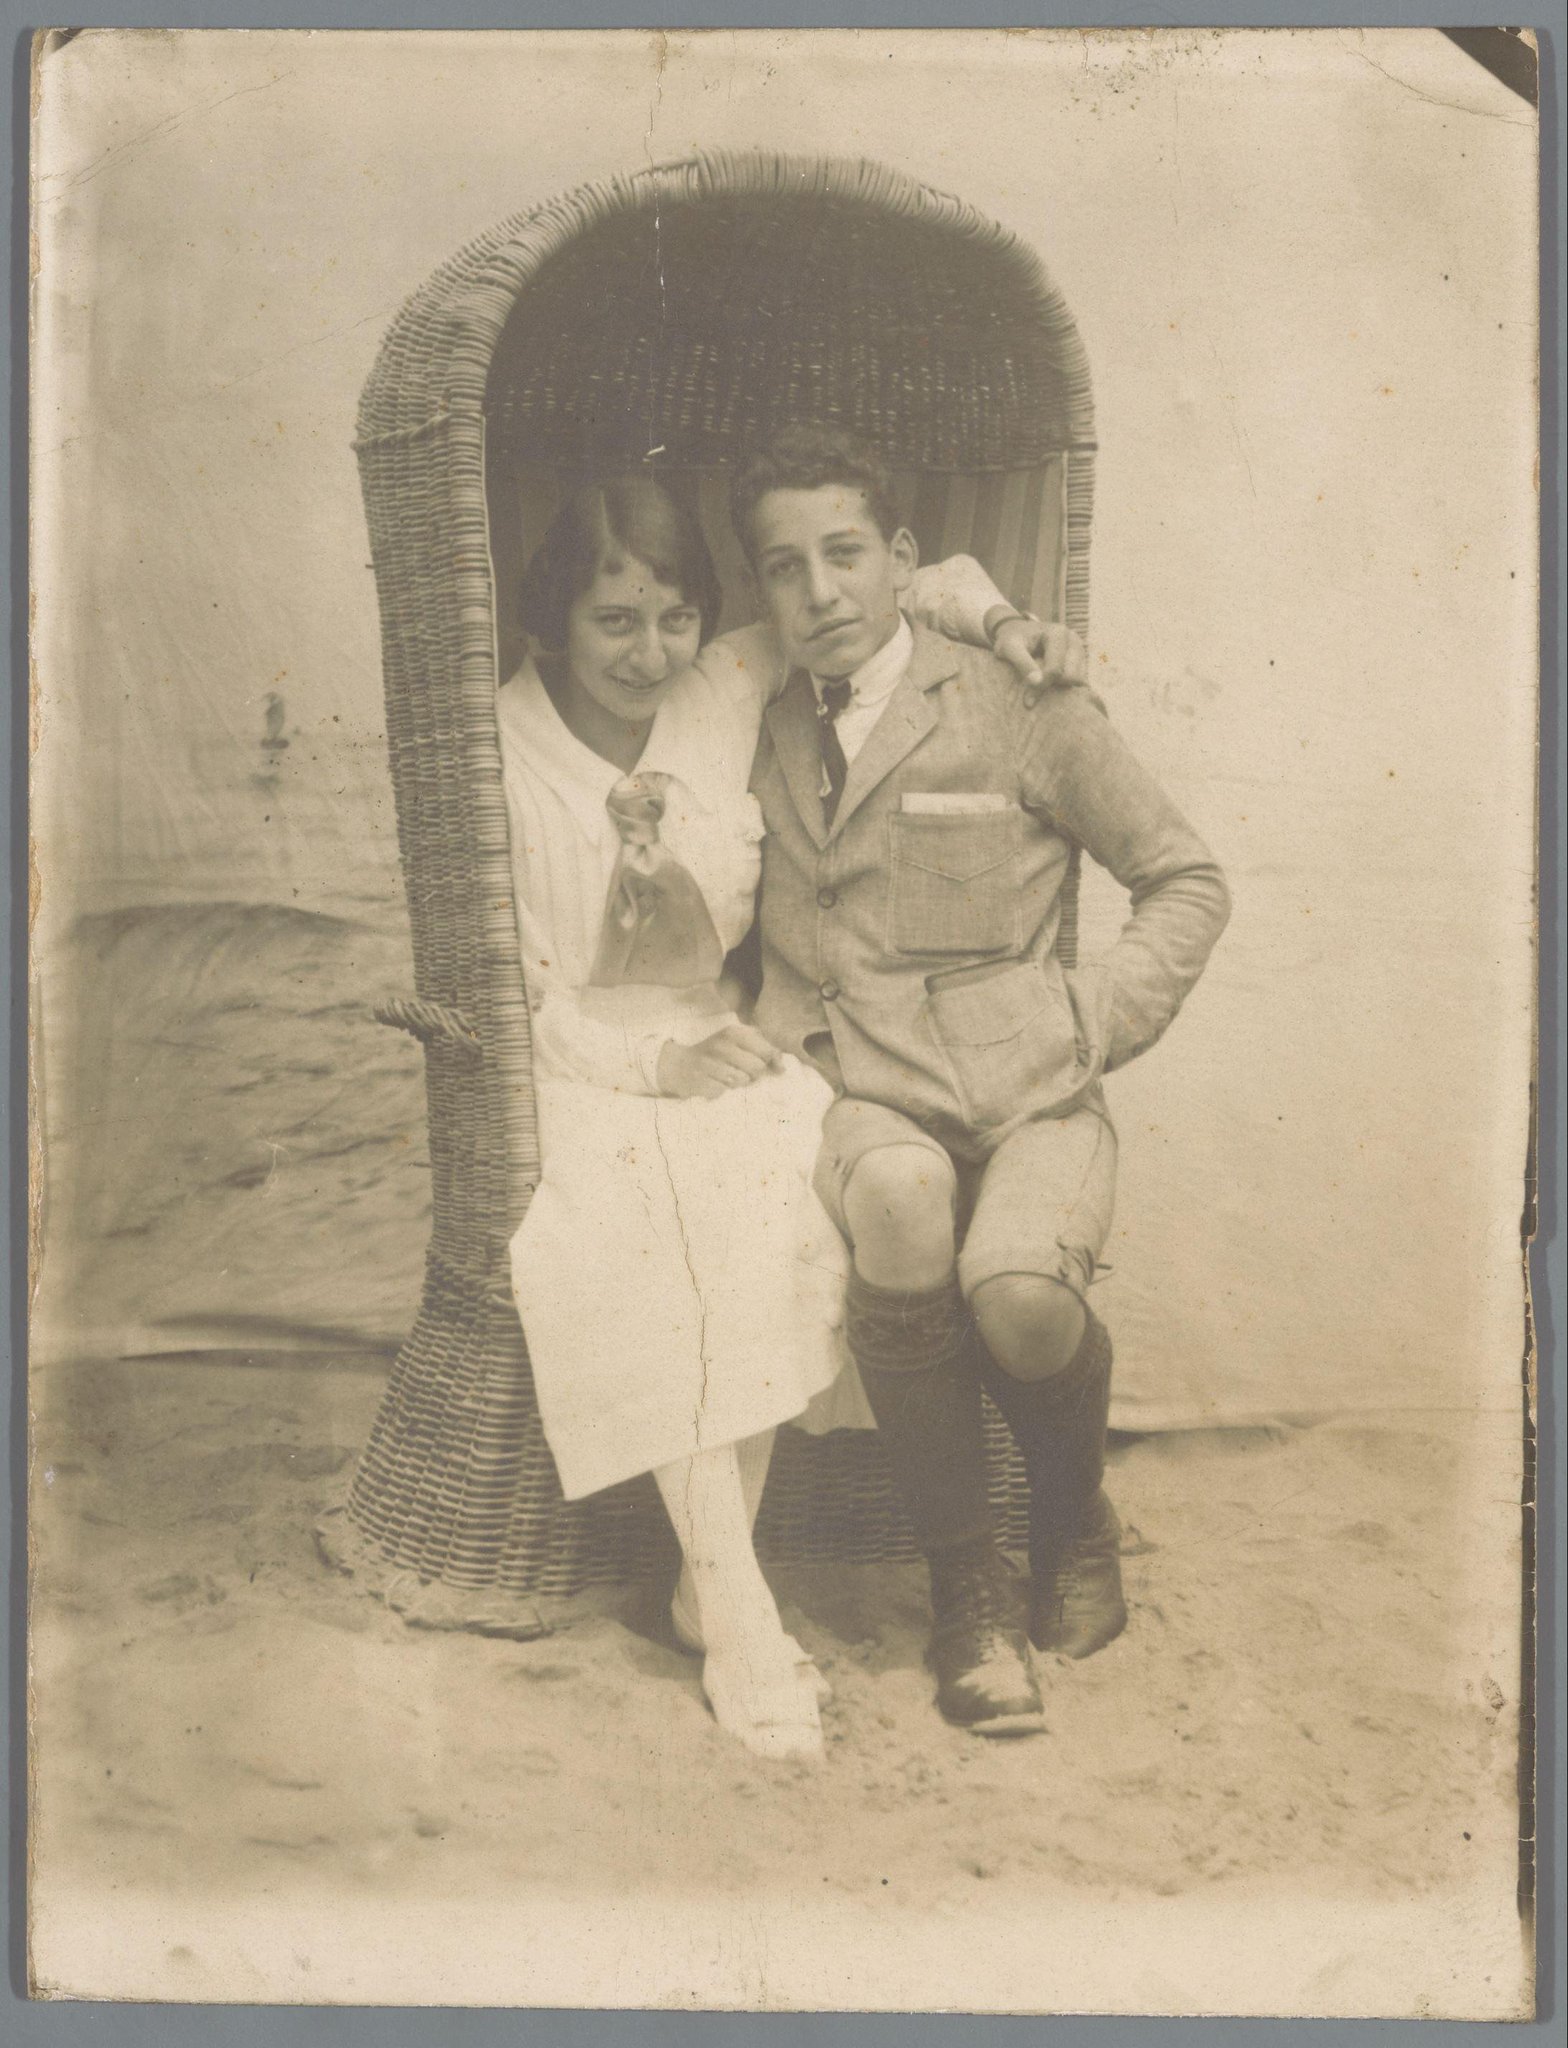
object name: photograph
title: Studioportret van een onbekende jongen en meisje op een rieten strandstoel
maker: f. brauckman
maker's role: fotograaf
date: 1910-1935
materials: photographic support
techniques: gelatin silver print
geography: zandvoort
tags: adolescent, young woman, maiden, studio ~ photographer, youth, adolescent, chair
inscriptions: inscription: ‘Foto Huis F. Brauckman Nordzeebad Zandvoort (Holland), Piet Heinstraat 61 -Filial op het Strand Fotografie Artikelen -Ontwikkelen van Platen en Films. Specialiteit in Snelfotografie.’